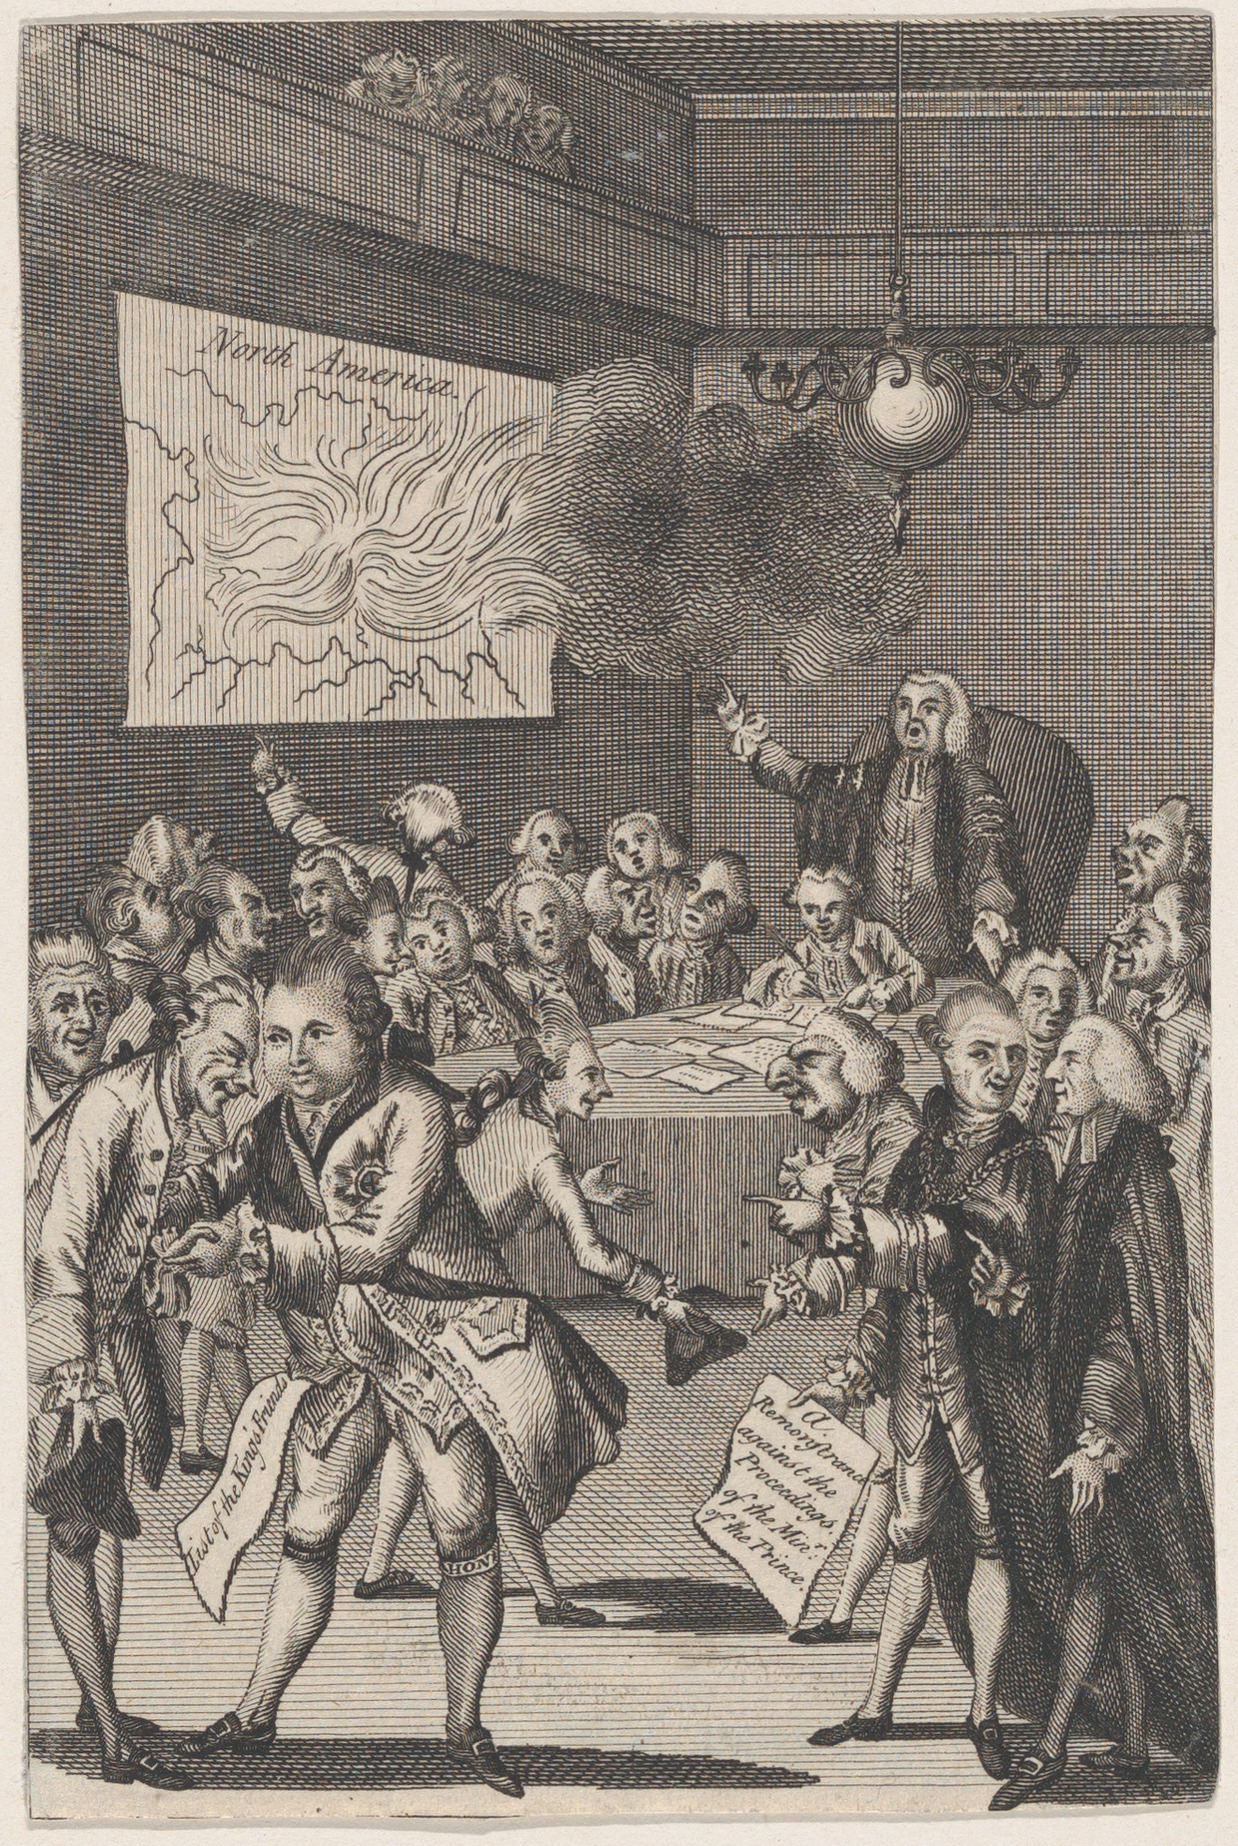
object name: print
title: The Council of Rulers & the Elders Against the Tribe of ye Americanites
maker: anonymous, british, 18th century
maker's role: artist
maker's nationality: british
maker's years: 1700-1800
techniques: engraving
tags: satire,american revolution,men,women,politics